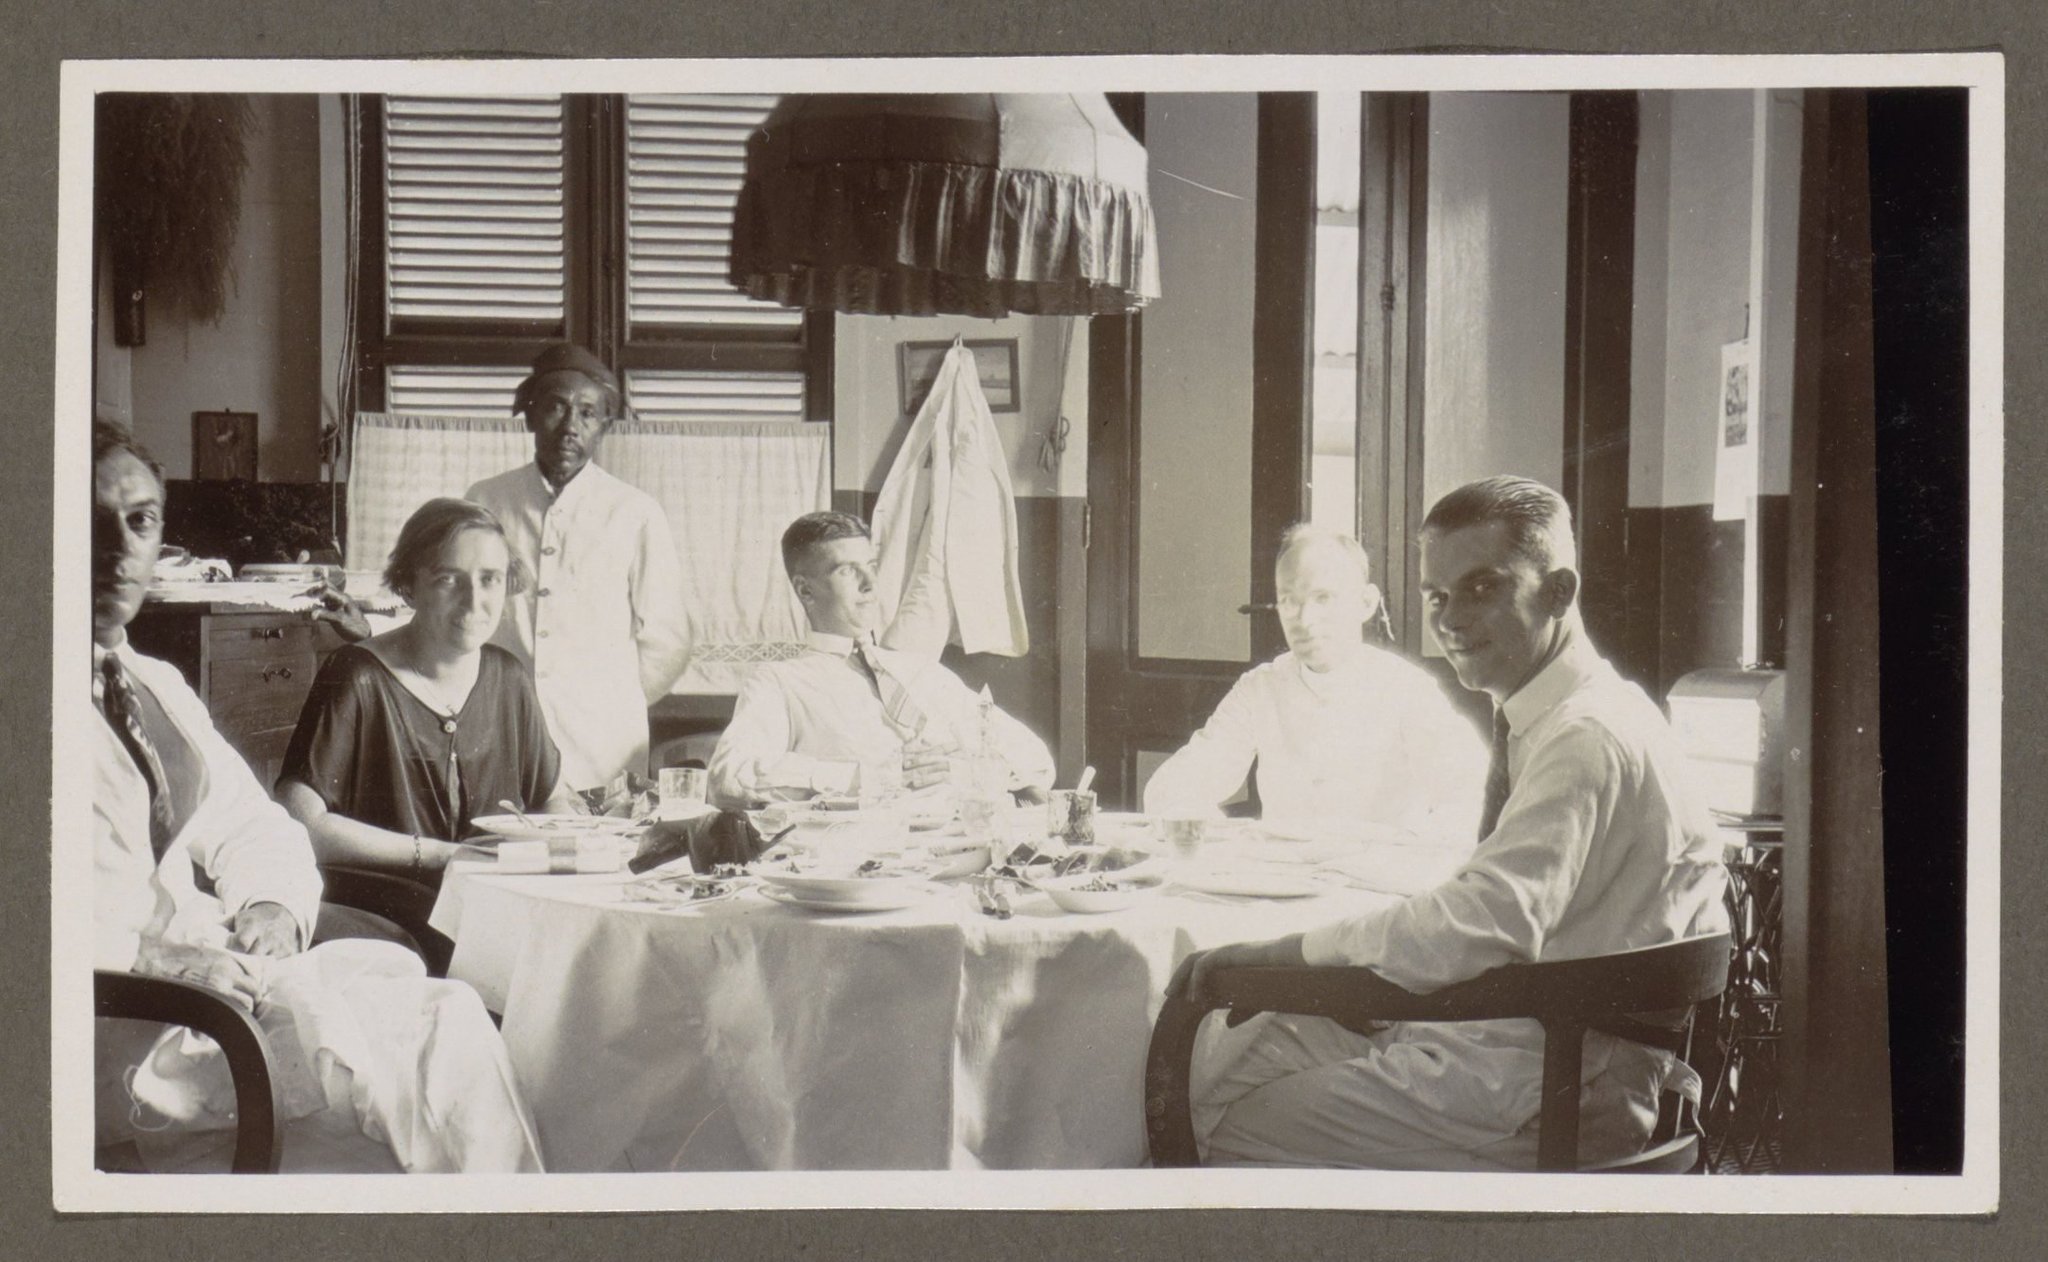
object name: photograph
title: Indonesische bediende, Europese mannen en een vrouw rondom een tafel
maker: Anonymous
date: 1920-1930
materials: photographic support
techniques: gelatin silver print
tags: interior of the house, house personnel, servants, dutch east indies, the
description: Vier Europese mannen in witte kledij en een vrouw zitten aan een gedekte tafel met een wit tafelkleed. De raamluiken zijn gesloten. De stoffen kap van een hanglamp is nog juist zichtbaar. Staand voor het raam een Indonesische bediende met een hoofddeksel. Hij houdt zijn hand aan een schaal met serviesgoed. Onderdeel van familiealbum Nederlands-Indië.